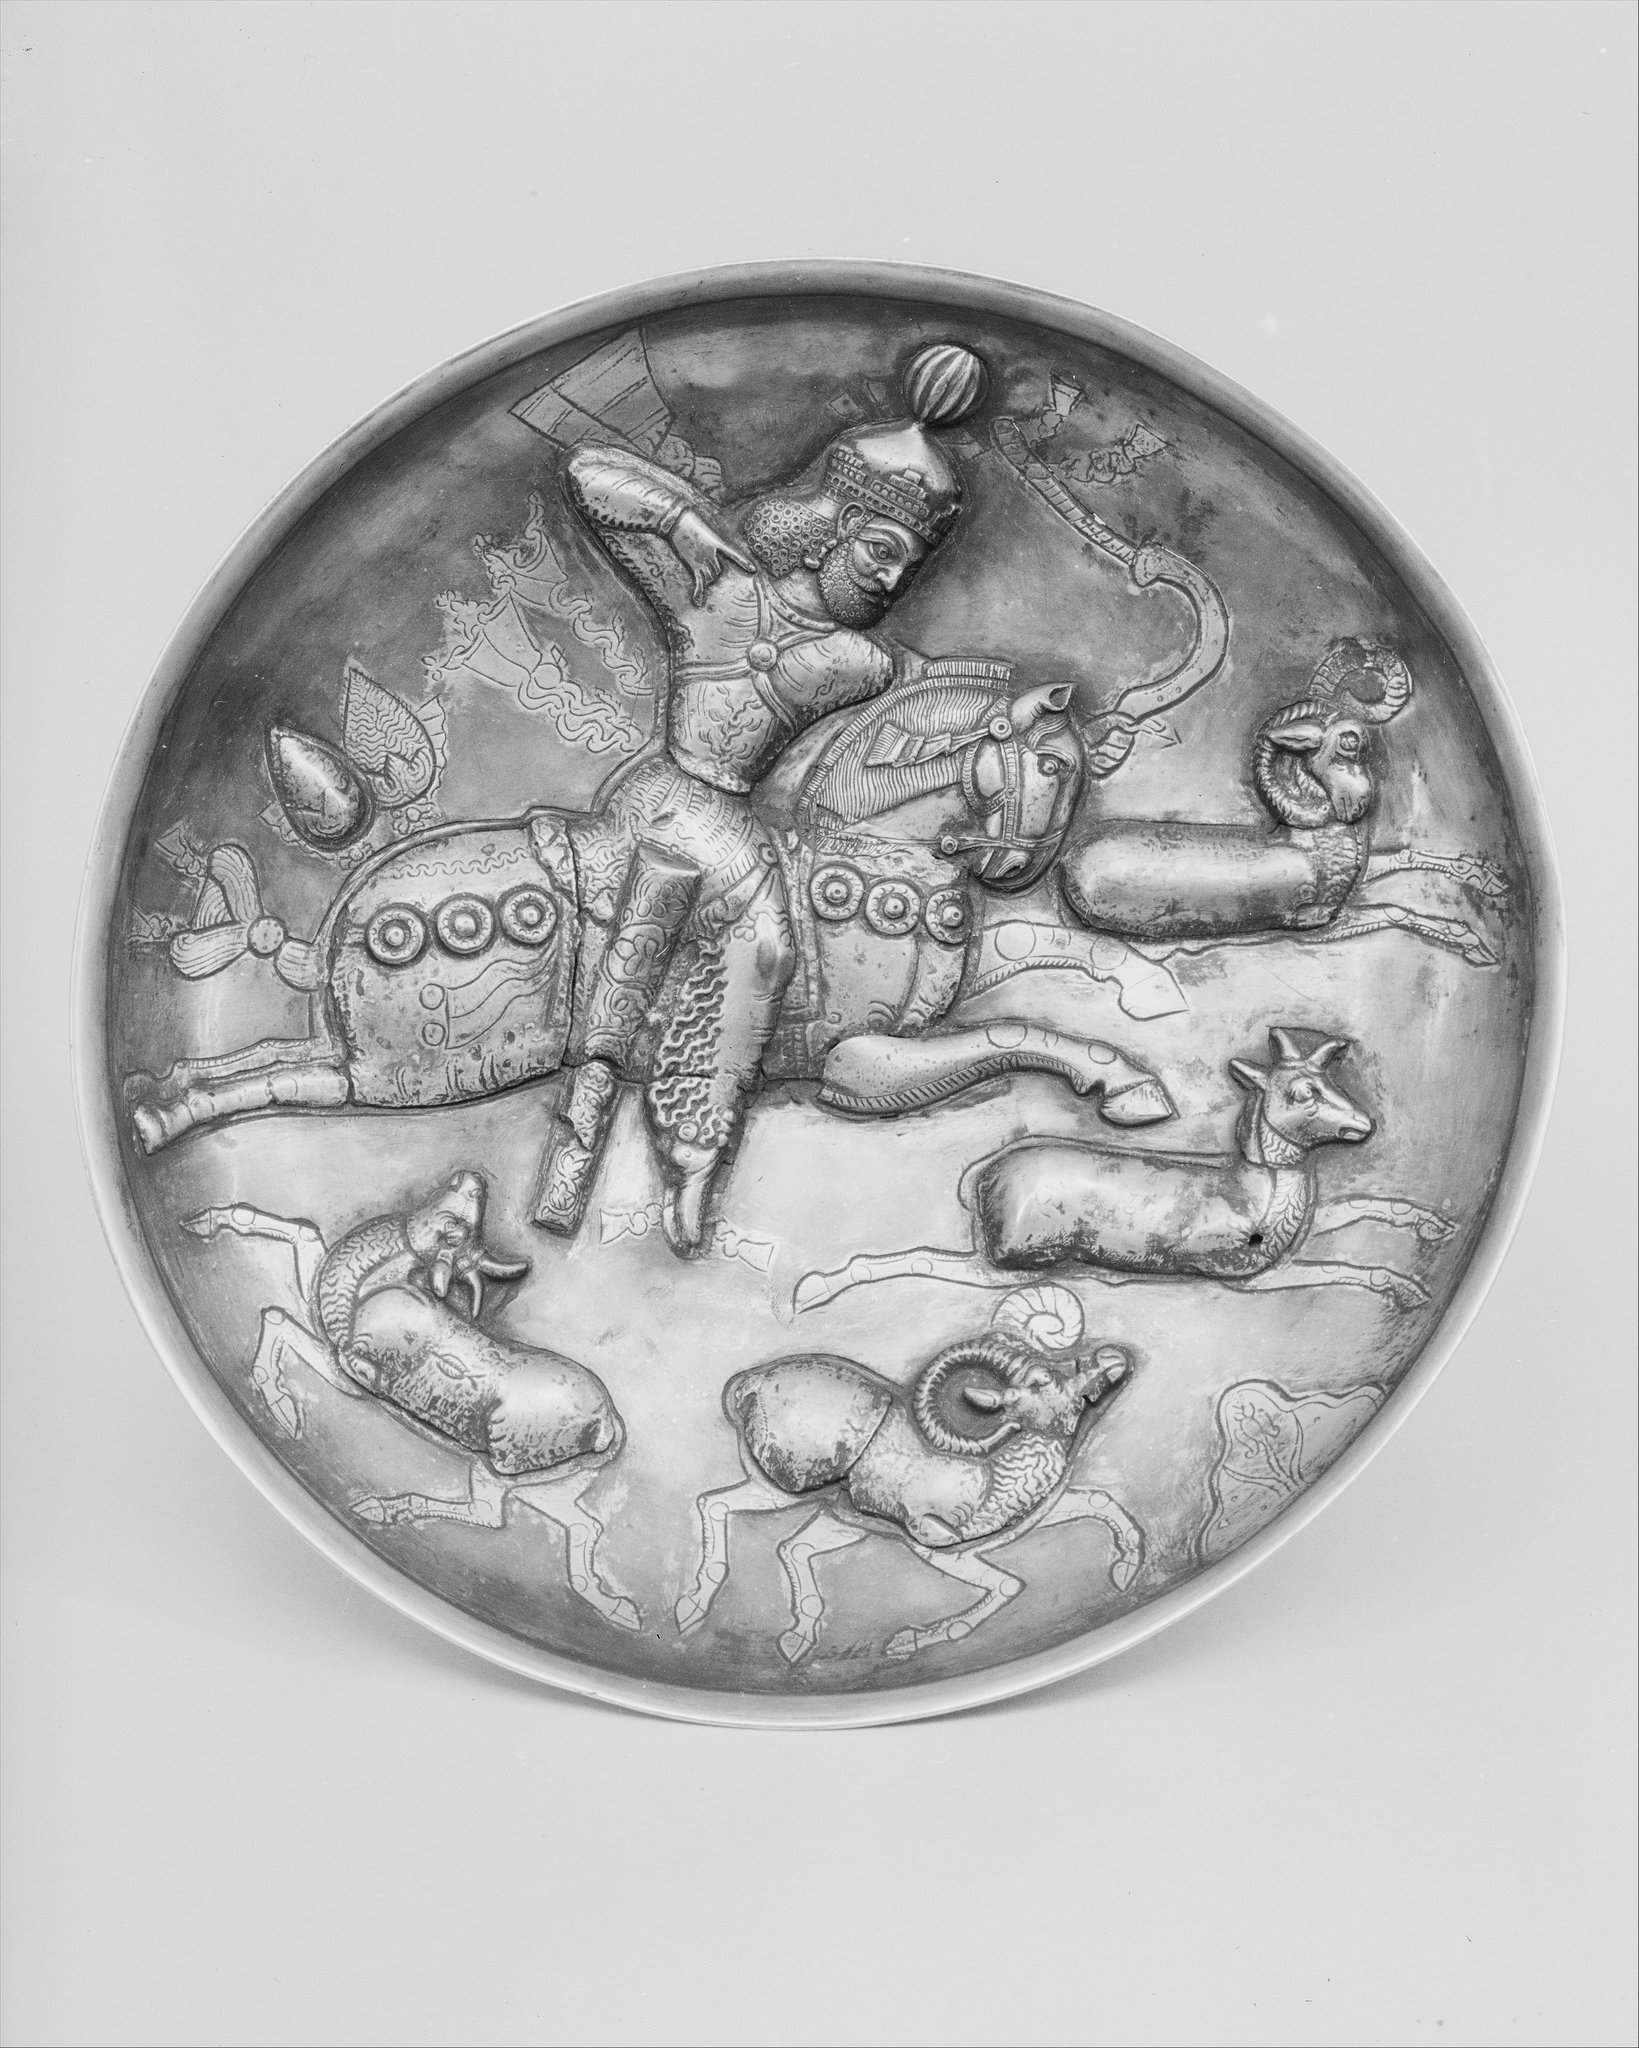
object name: plate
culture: sasanian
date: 310-379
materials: gilt, silver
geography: iran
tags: men,goats,horses,rams